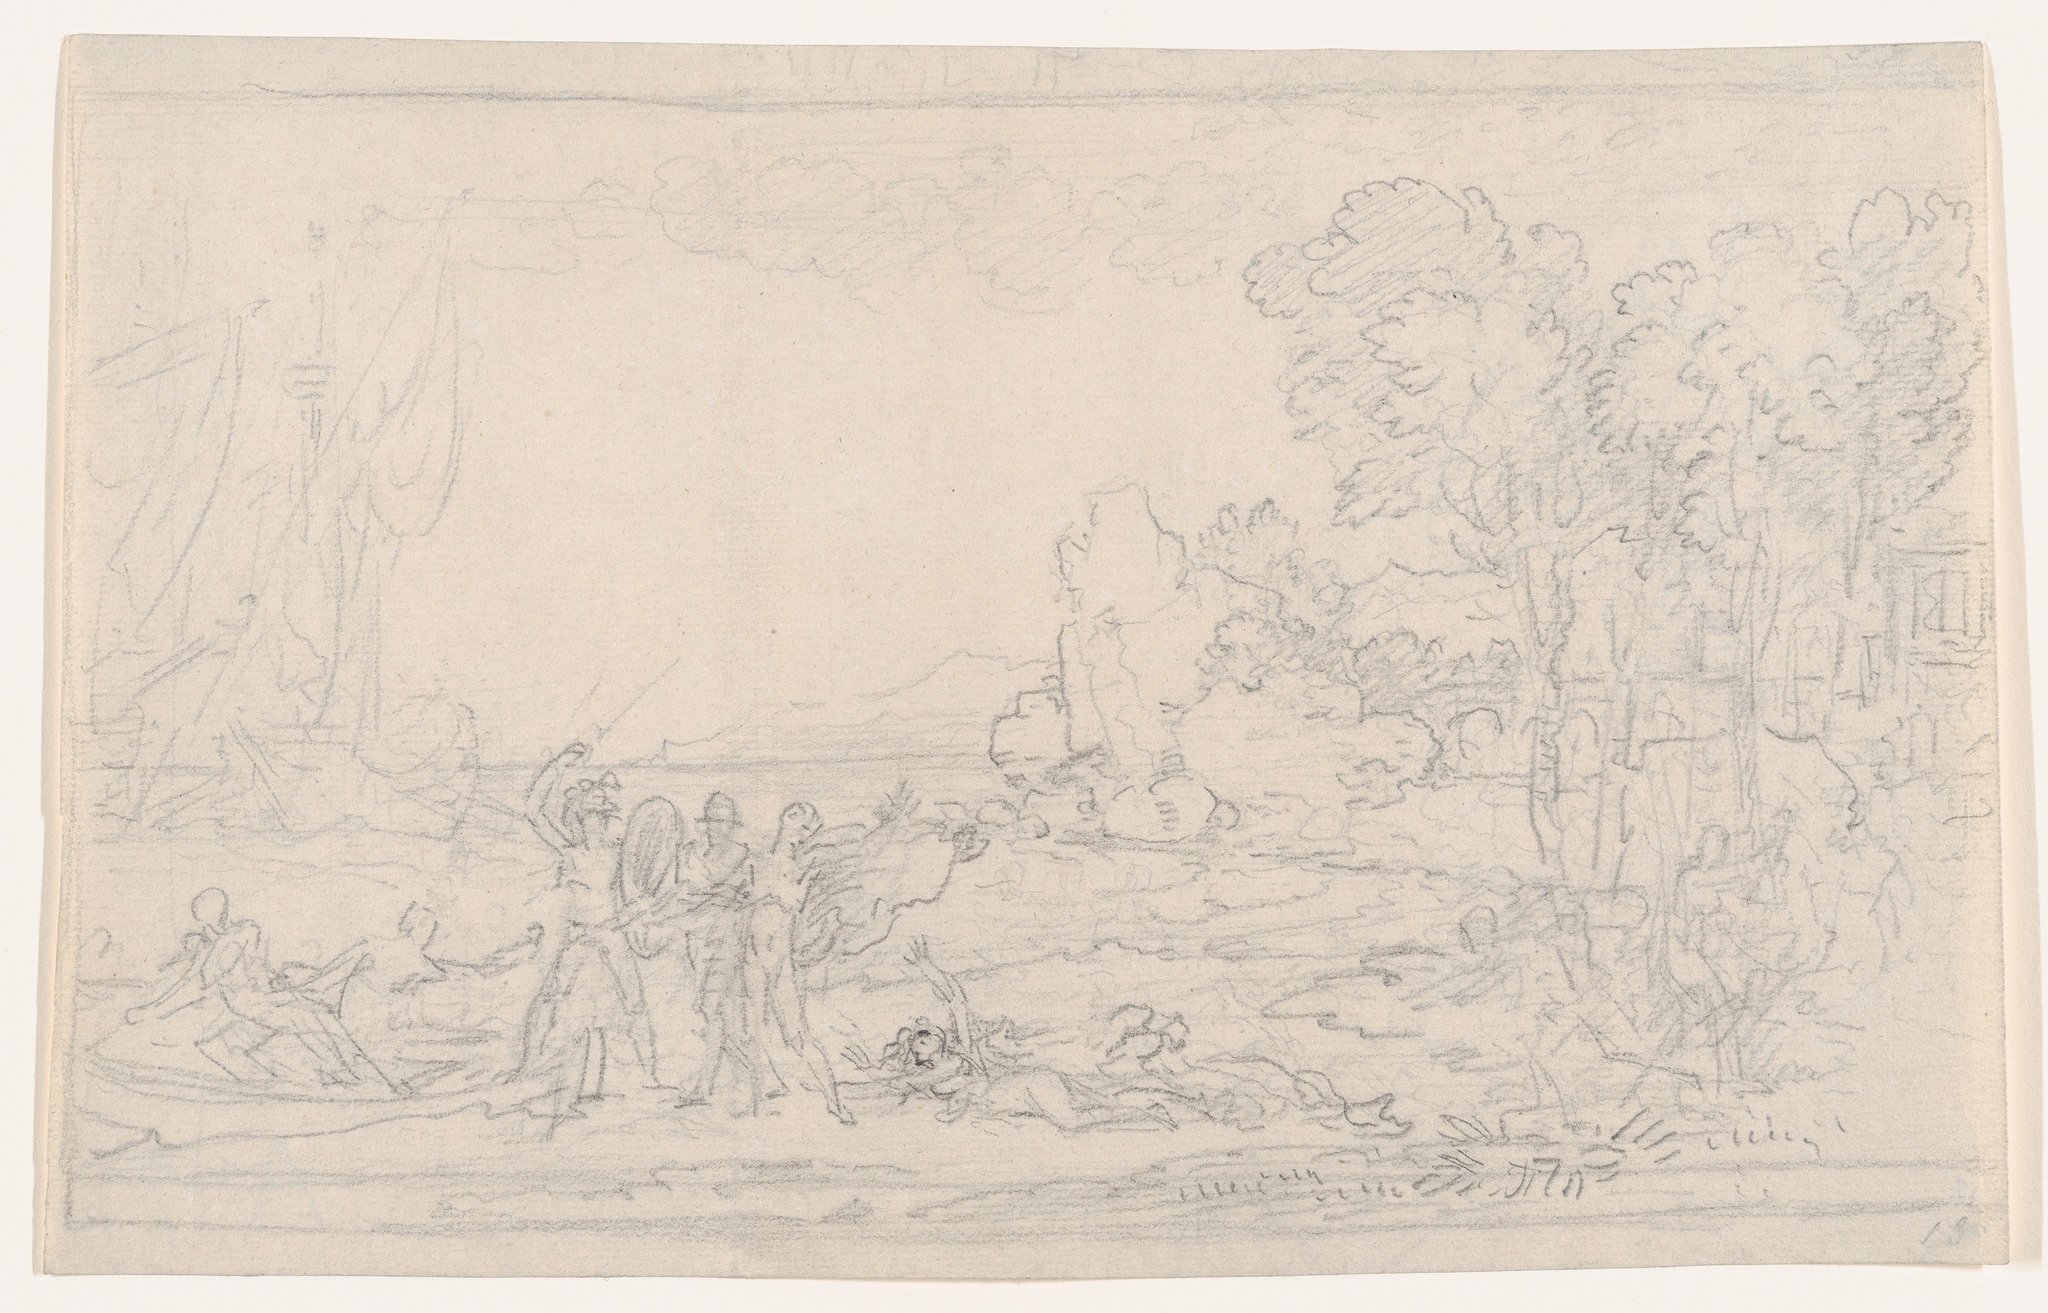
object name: drawing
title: Rinaldo rescued from Armida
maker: benjamin west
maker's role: artist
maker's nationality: american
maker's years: 1738-1820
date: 1766-1800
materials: graphite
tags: men,women,landscapes